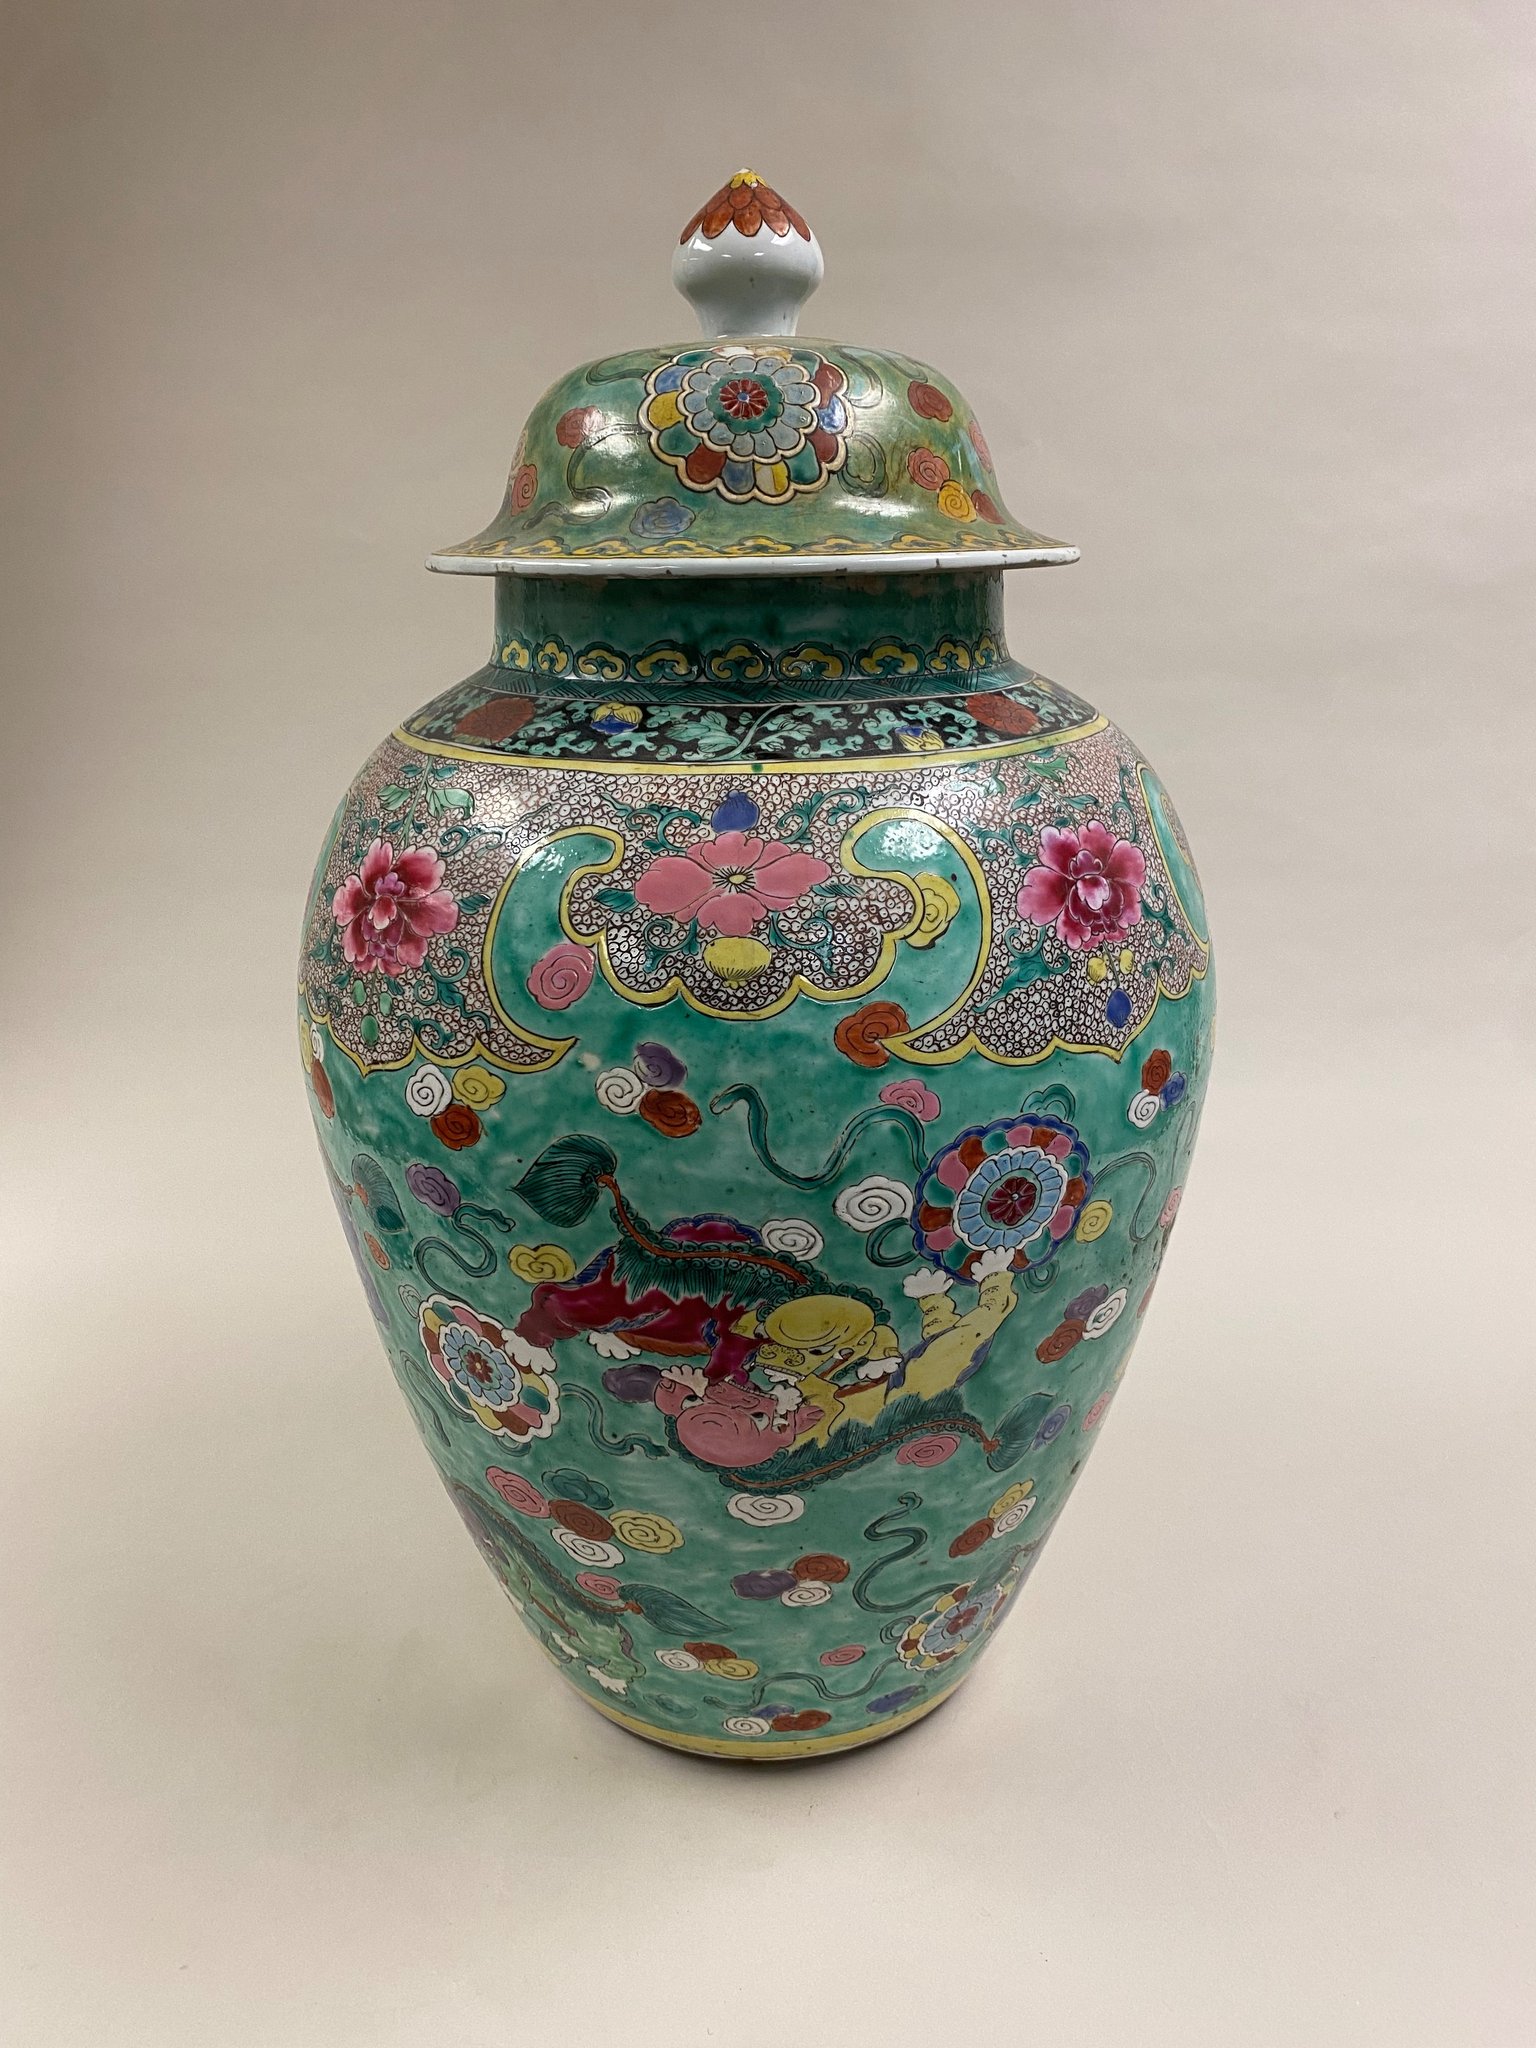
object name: covered jar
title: Covered jar with lions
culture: chinese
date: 1801-1900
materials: enamel, porcelain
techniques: overglaze, painting, polychrome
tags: lions